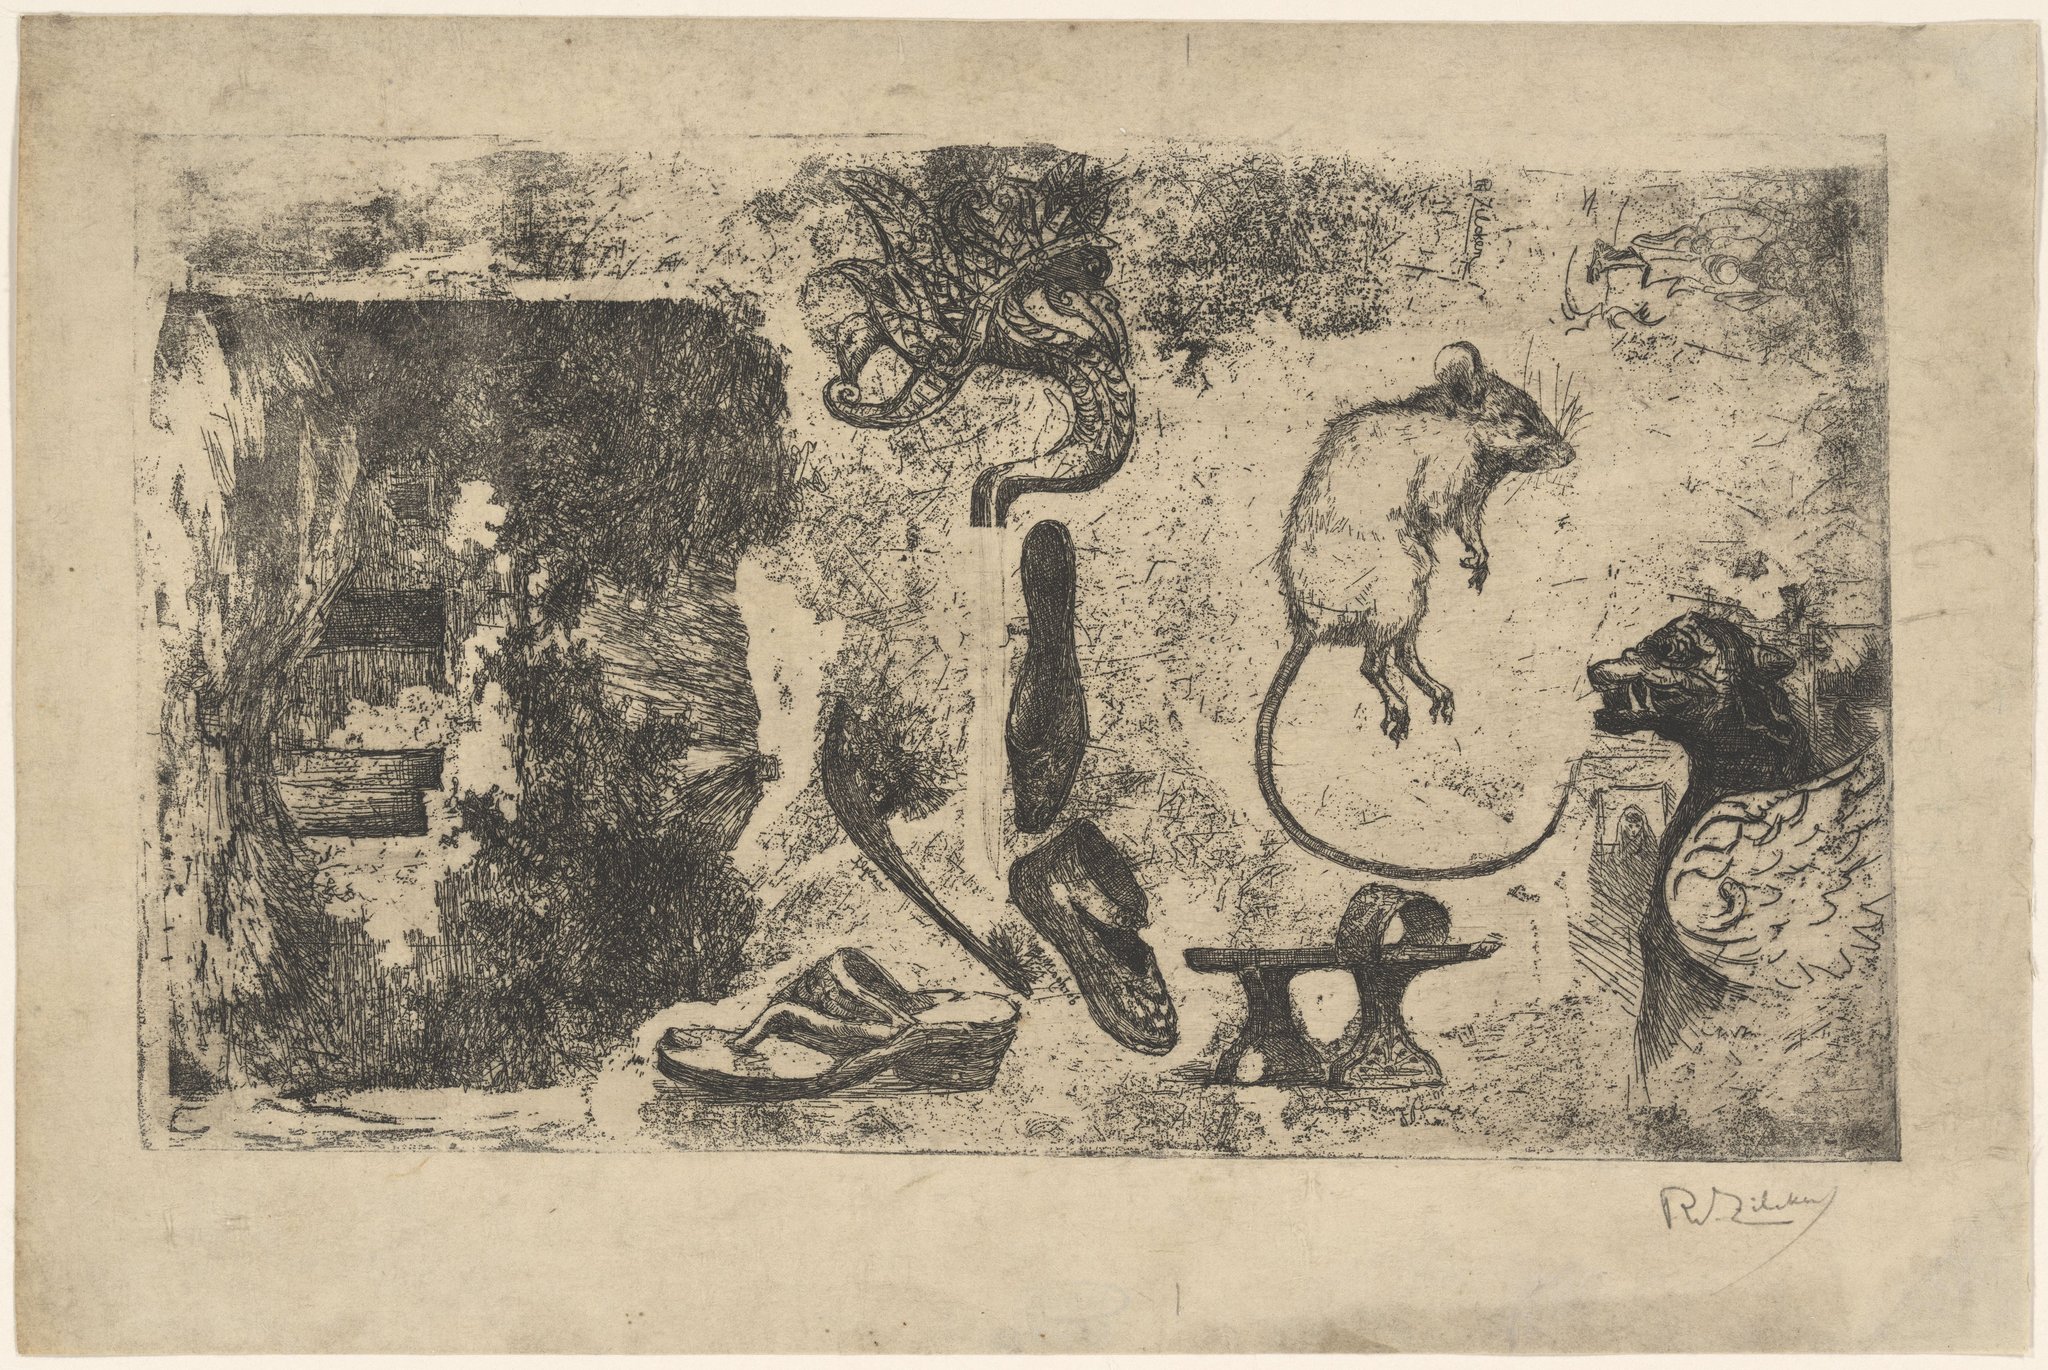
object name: print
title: Sandalen, een dode muis, een chimère, boegbeeld van een schip en een boerderij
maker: philip zilcken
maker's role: draughtsman, painter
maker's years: 1857-1930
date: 1867-1890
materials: paper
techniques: drypoint, etching, intaglio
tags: rodents: mouse, shoes, sandals, parts of ship's exterior: figure-head, farm (building)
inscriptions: collector's mark: Lugt 2228